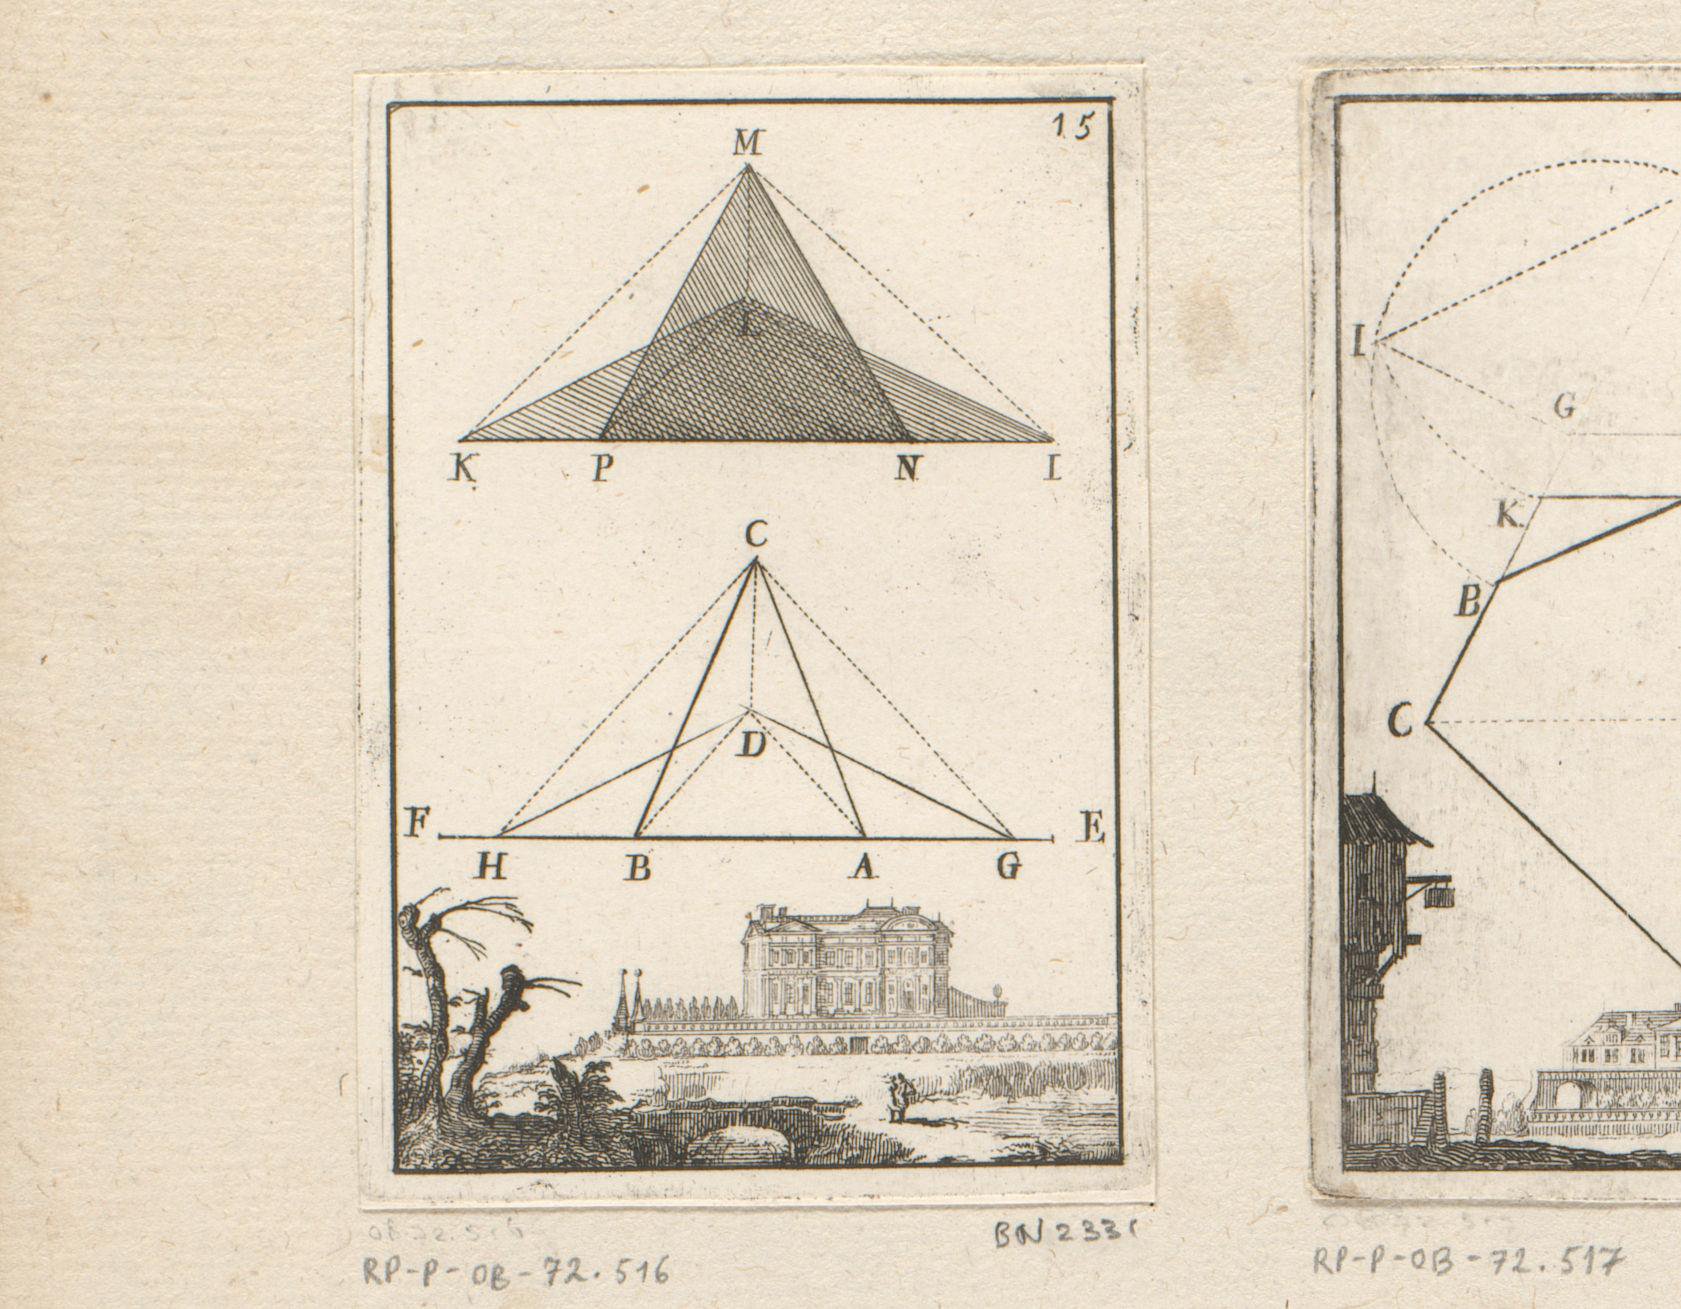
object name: book illustration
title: Verhoging van een driehoek met onderaan een gezicht op een paleis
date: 1669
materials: paper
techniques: etching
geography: paris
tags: palace, planimetry, geometry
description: Prent toegevoegd aan: Pratique de la géometrie, sur le papier et sur le terrain. Avec un nouvel ordre et une méthode particulière. Parijs: Thomas Jolly, 1669.